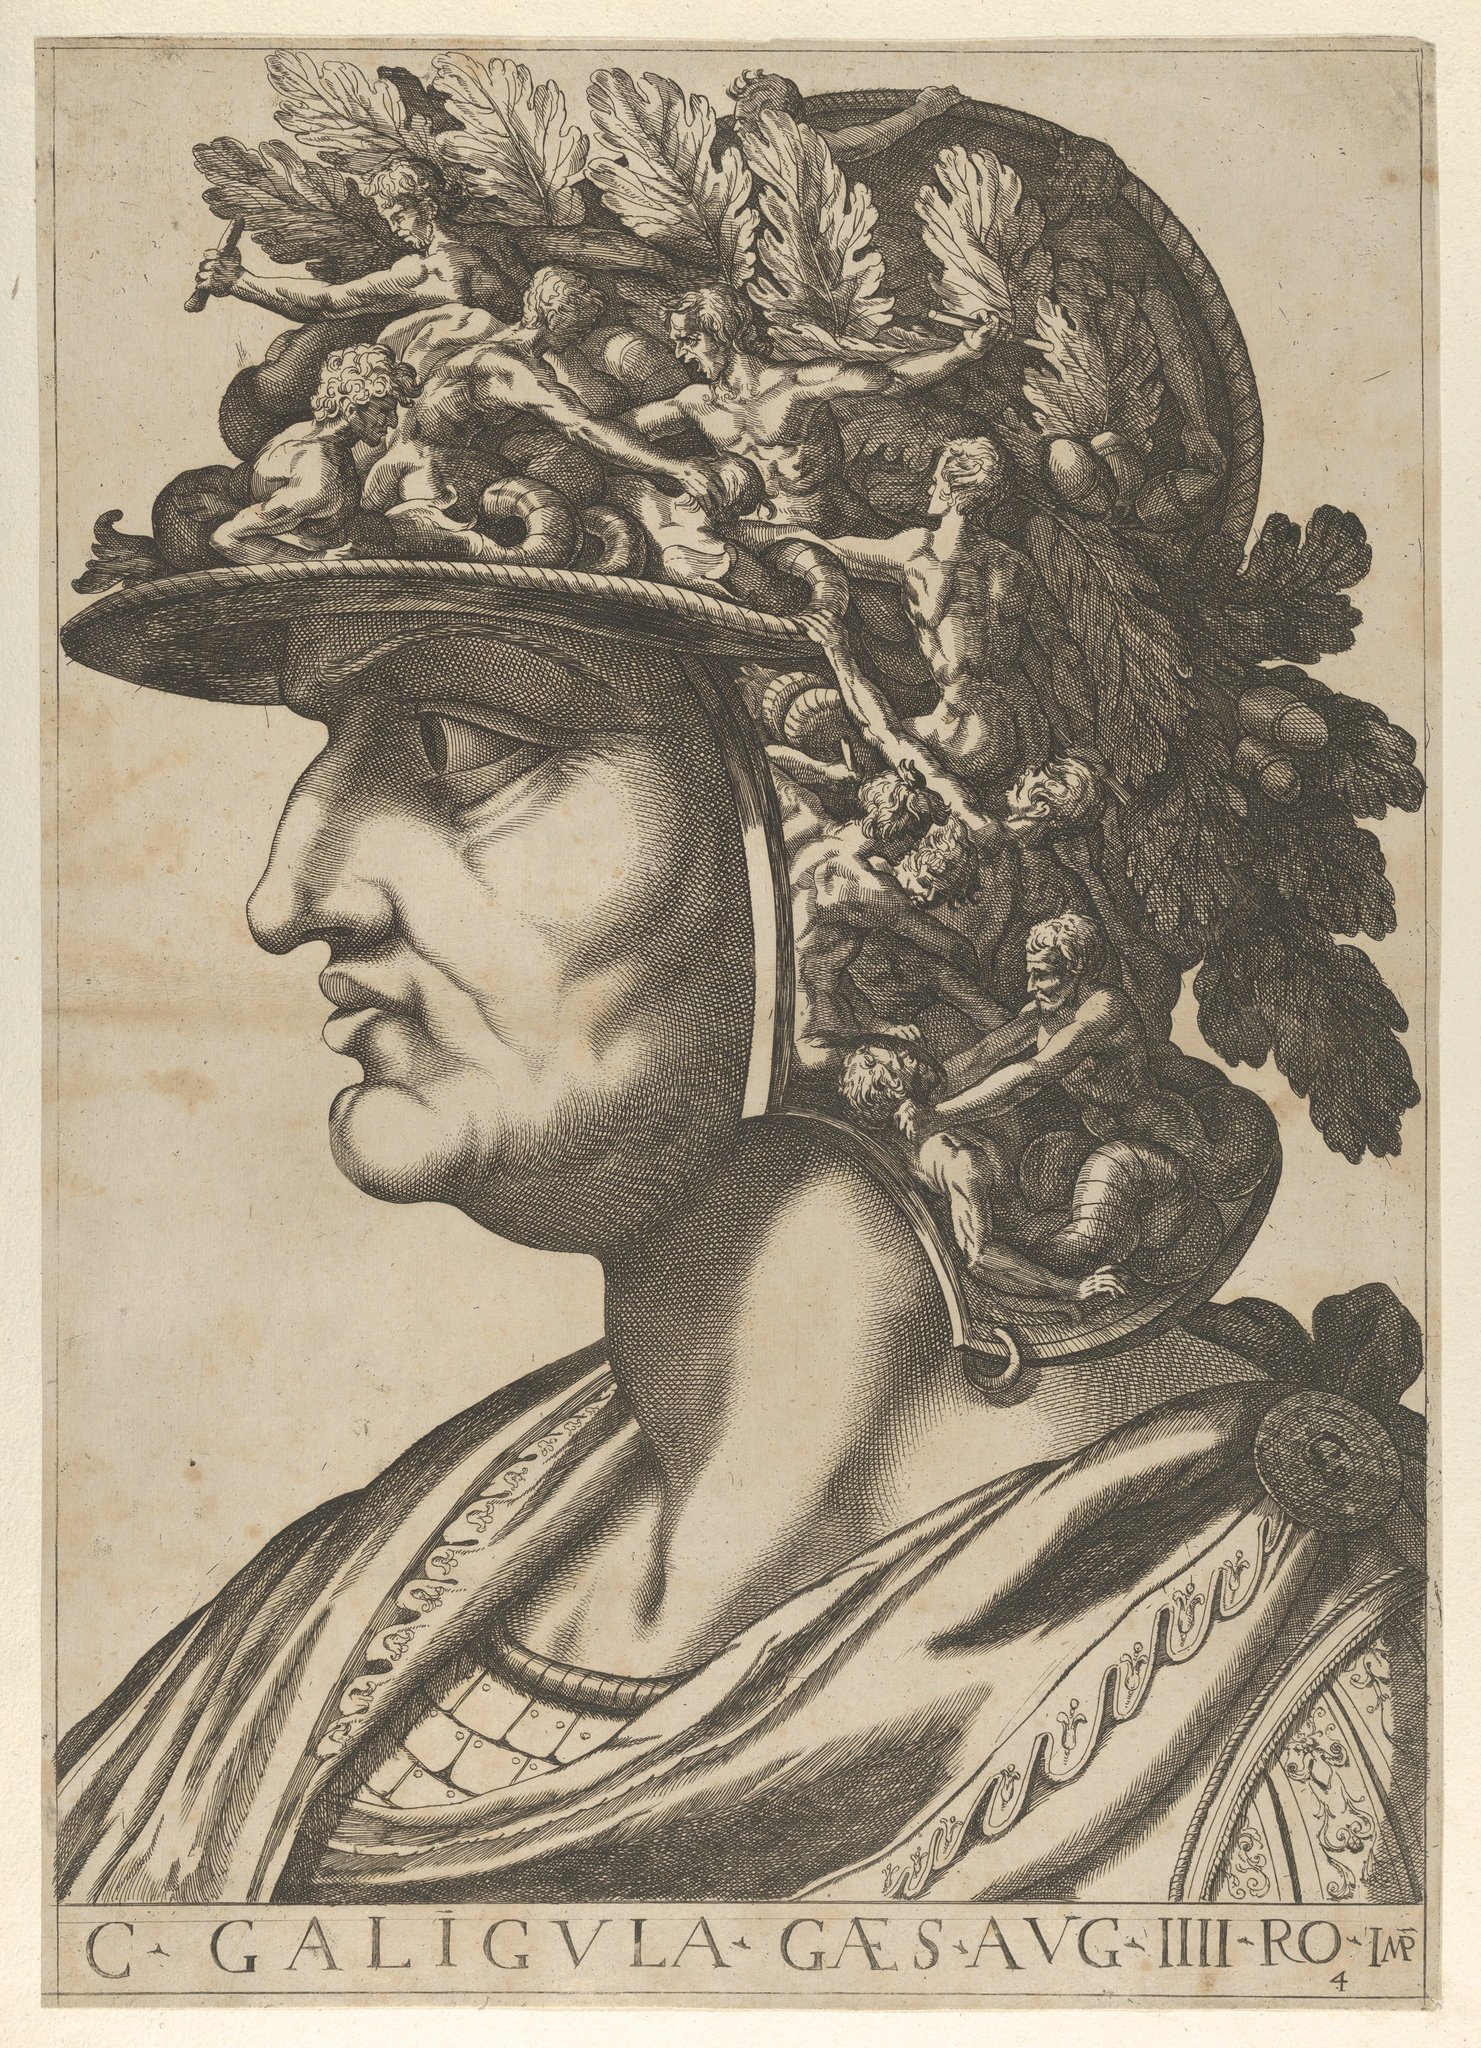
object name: print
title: Plate 4: Caius in profile facing left, from "The Twelve Caesars"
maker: Anonymous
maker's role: artist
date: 1610-1640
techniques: engraving, etching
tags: men,profiles